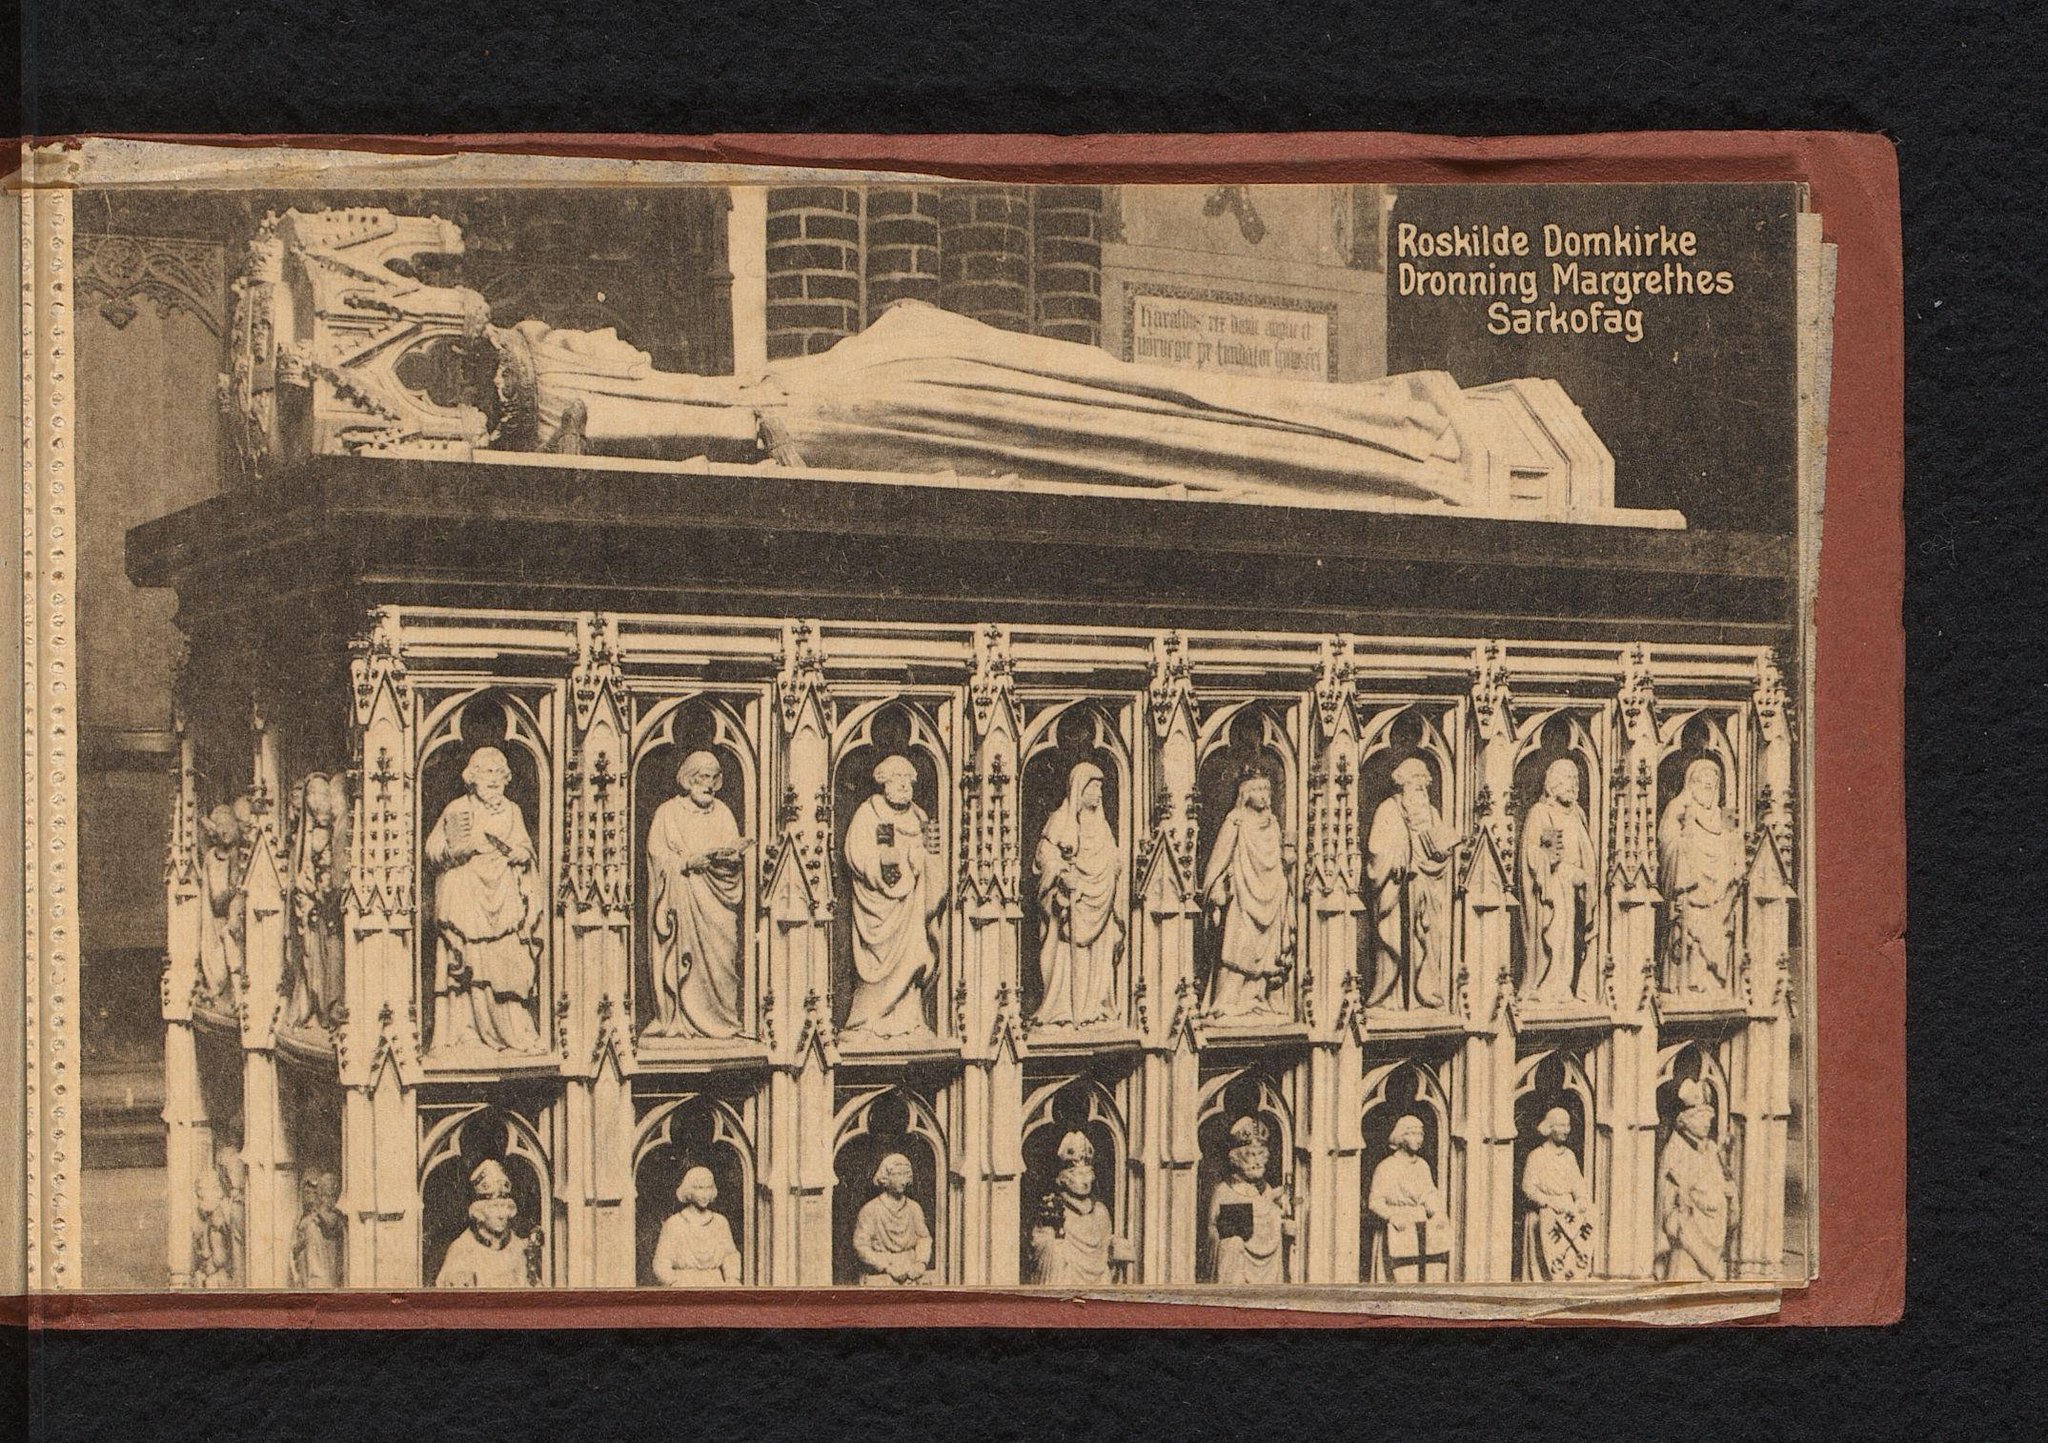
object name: ansichtkaart, prentbriefkaart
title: Dronning Margrethes Sarkofag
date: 1906-1920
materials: cardboard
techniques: photograph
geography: roskilde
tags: grave, tomb, interior of church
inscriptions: mark: ‘CS’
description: Prentbriefkaart maakt deel uit van een album.